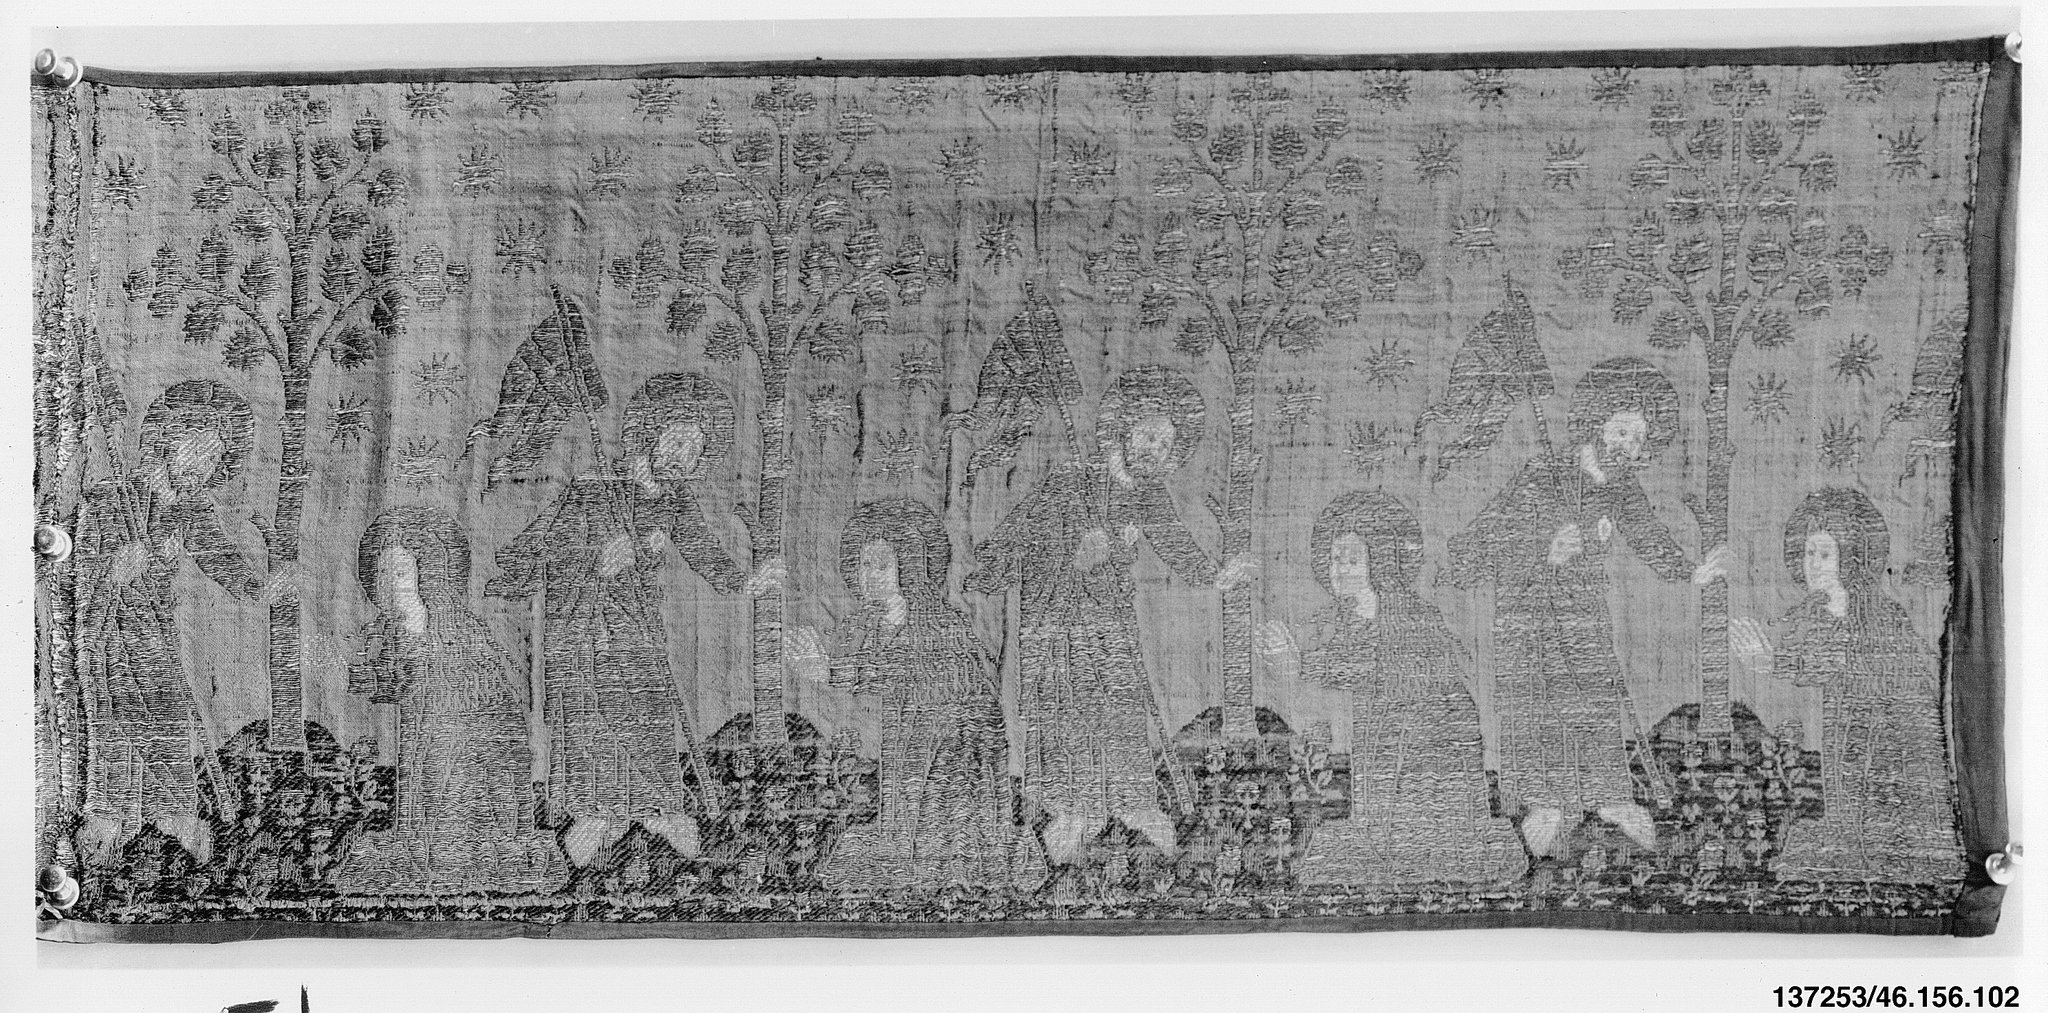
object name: border or apparel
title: Noli Me Tangere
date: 1401-1433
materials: metal thread, silk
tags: trees,christ,mary magdalene